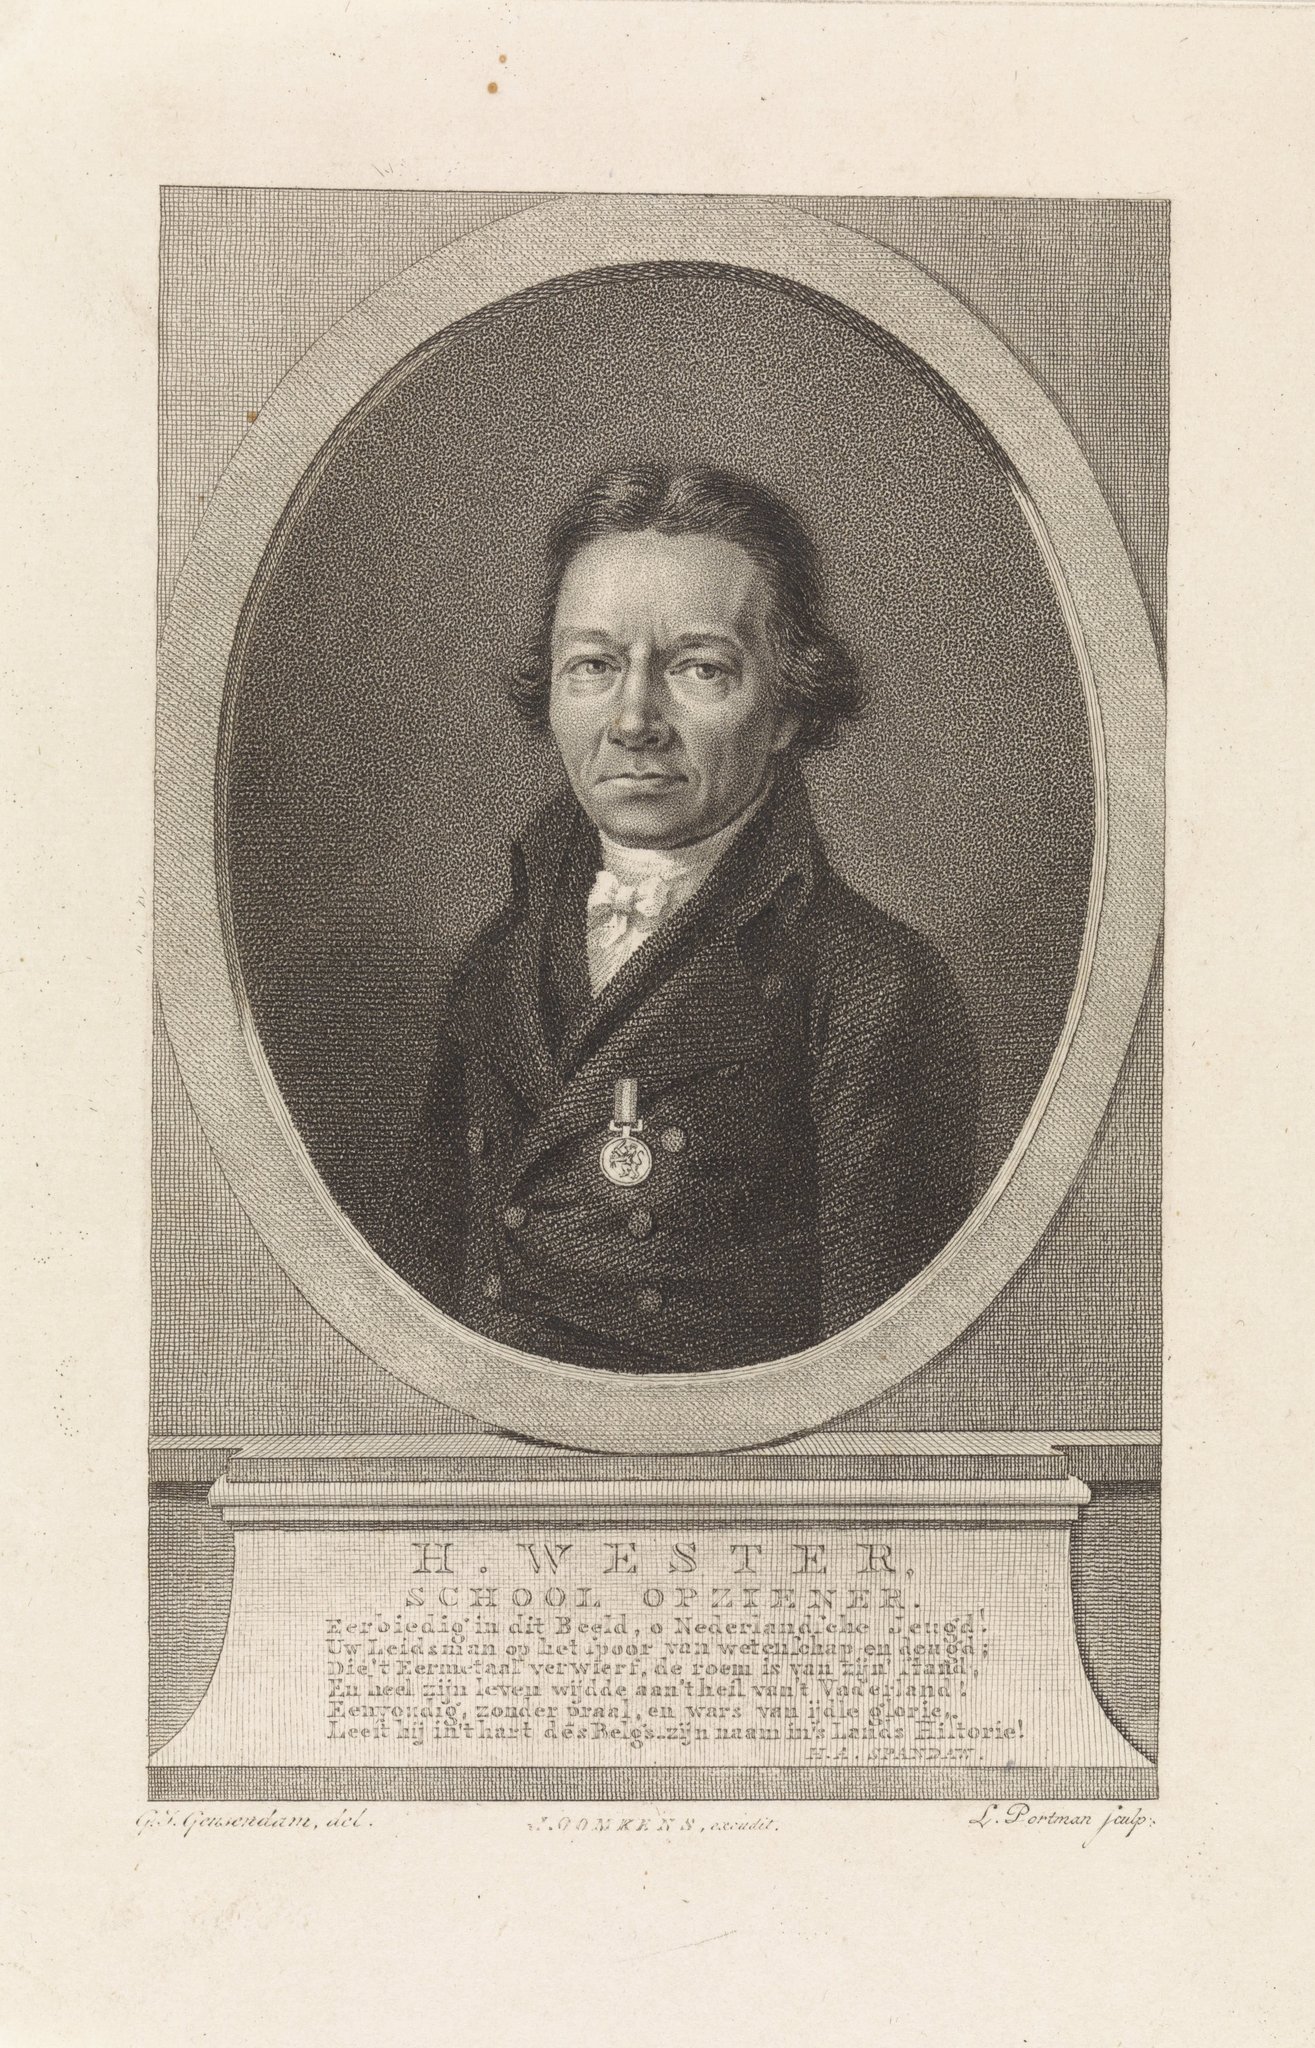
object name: print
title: Portret van onderwijzer Hendrik Wester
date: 1782-1828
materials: paper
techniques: etching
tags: decorations, honours (as symbols of the state, etc.)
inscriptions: collector's mark: Lugt 2228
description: Hij draagt een medaille op zijn jas. Op de piëdestal een zesregelig lofdicht in het Nederlands.